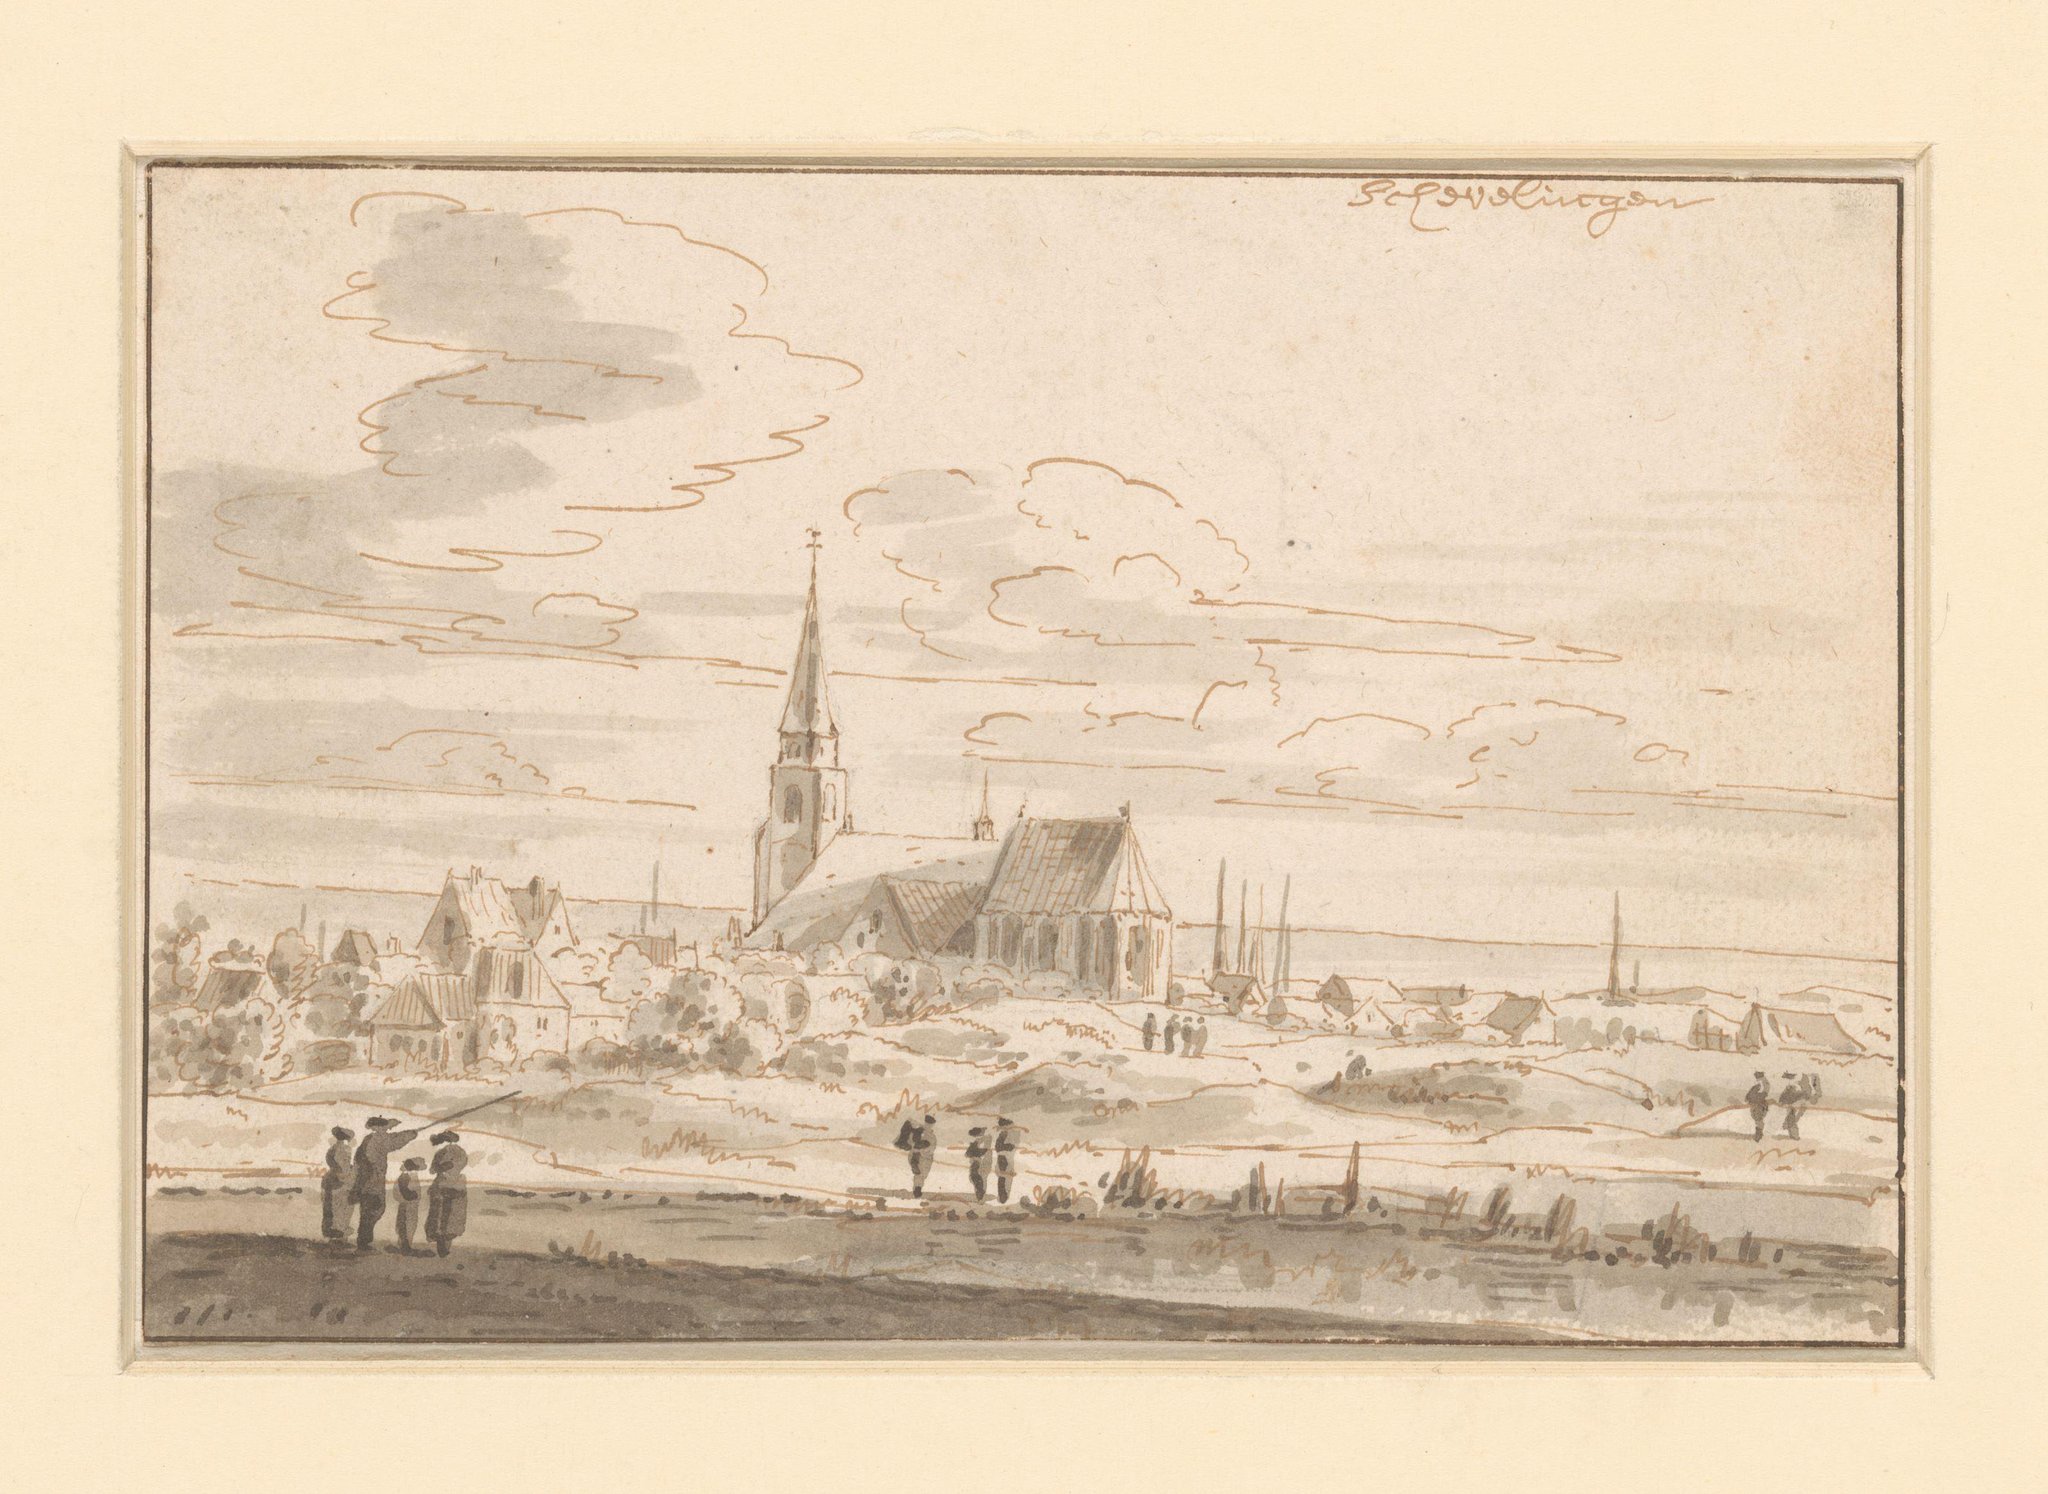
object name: drawing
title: Schevelingen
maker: Anonymous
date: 1700-1799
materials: ink, paper, pencil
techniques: drawing, pen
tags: church (exterior), beach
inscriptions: collector's mark: Lugt 2228